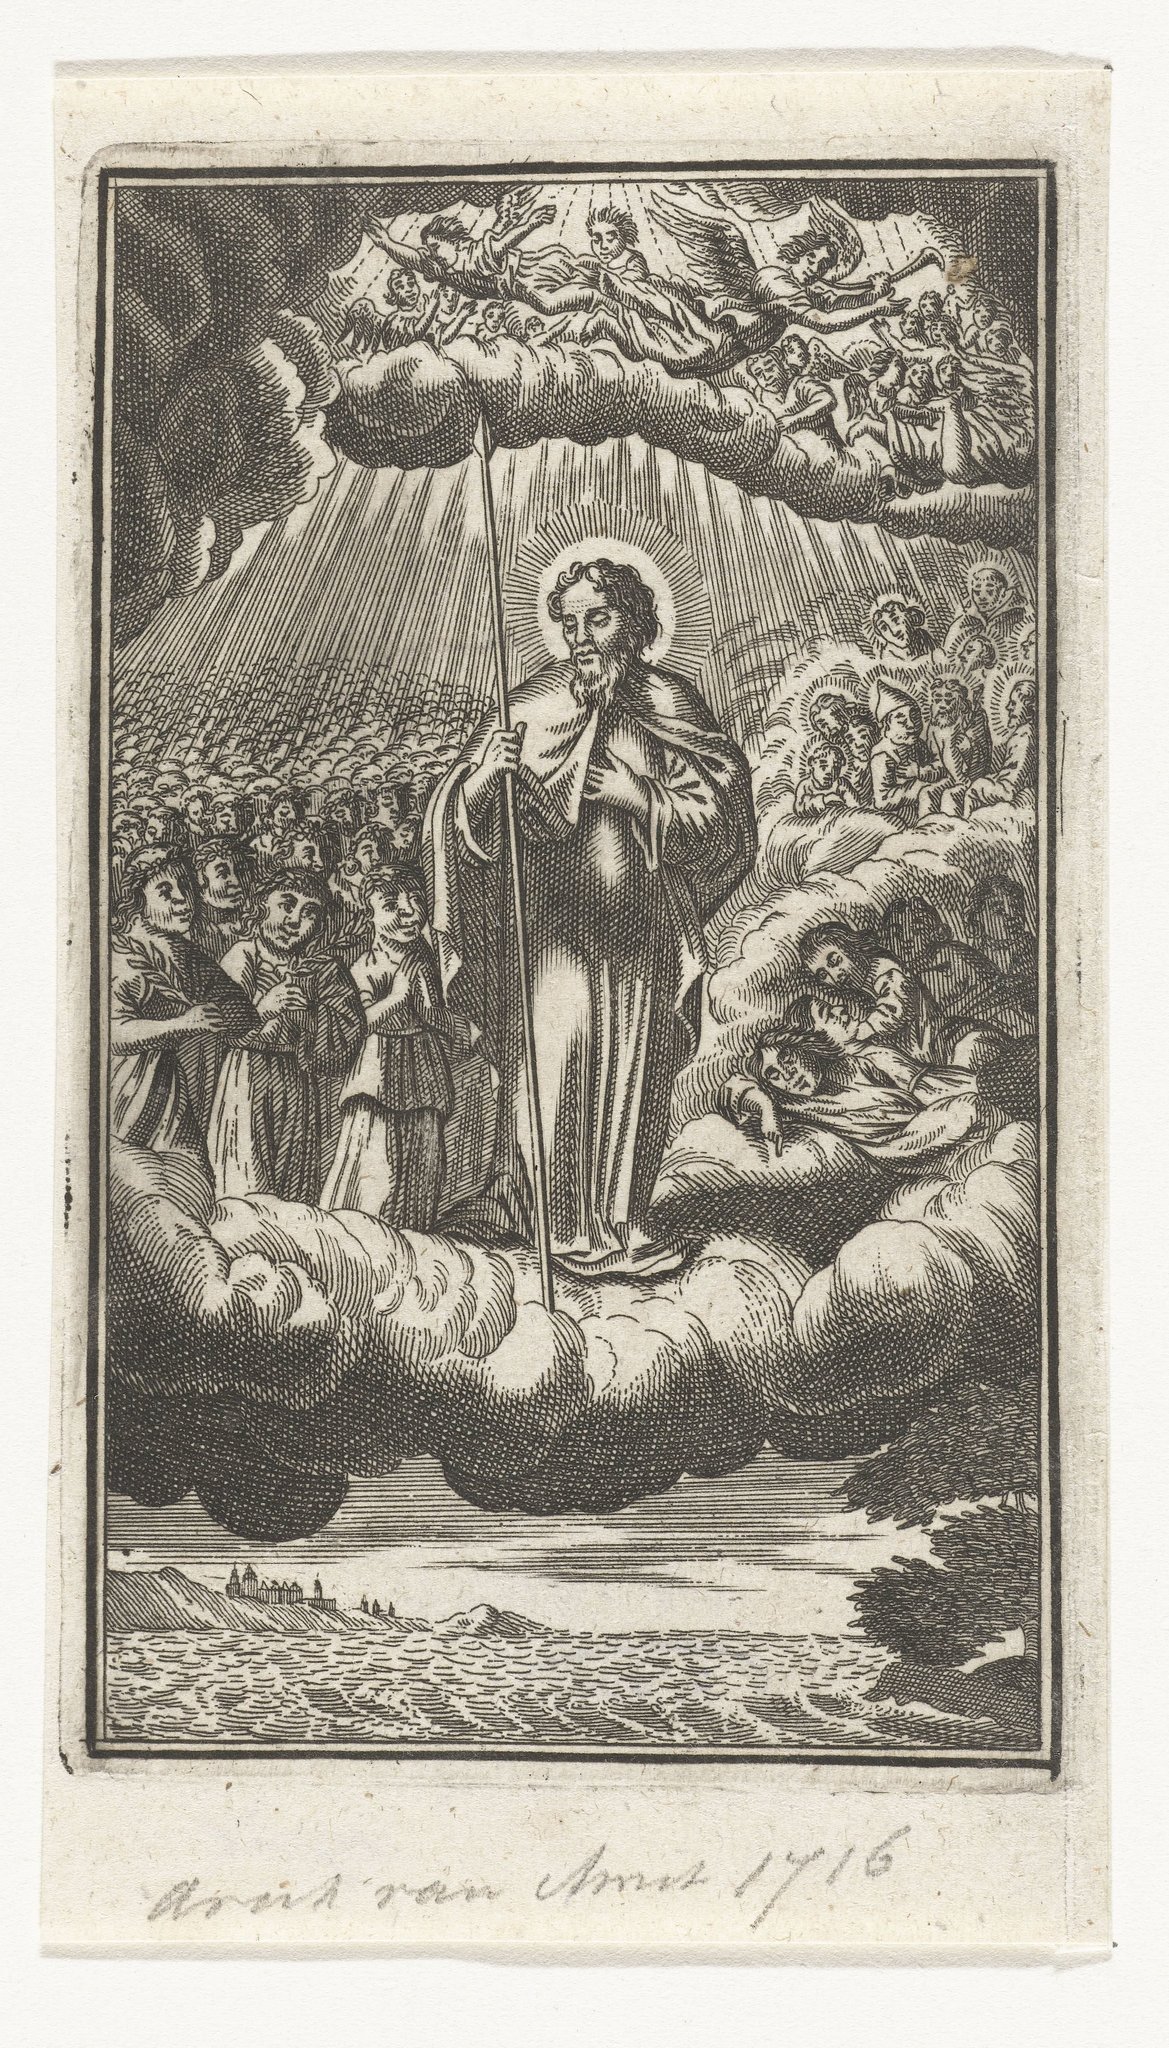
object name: print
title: Heilige Thomas in de hemel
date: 1671-1716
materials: paper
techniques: engraving, etching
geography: amsterdam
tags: the apostle thomas; possible attributes: book, chalice, girdle, heart, lance or spear, scroll, square, stones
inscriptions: collector's mark: Lugt 2228a, inscription: ‘druk van Amst 1716’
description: De heilige Thomas staand op wolken, in zijn linkerhand een speer Aan zijn rechterhand zeven slapende personen, aan zijn linkerhand een groot aantal martelaren met palmtakken. Kopie in spiegelbeeld.